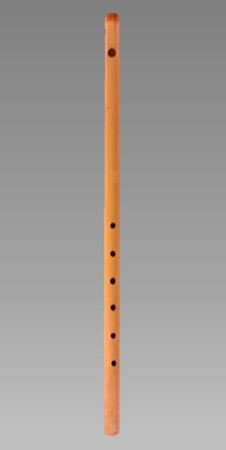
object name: transverse flute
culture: melanesian or philippine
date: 1867-1900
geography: new guinea